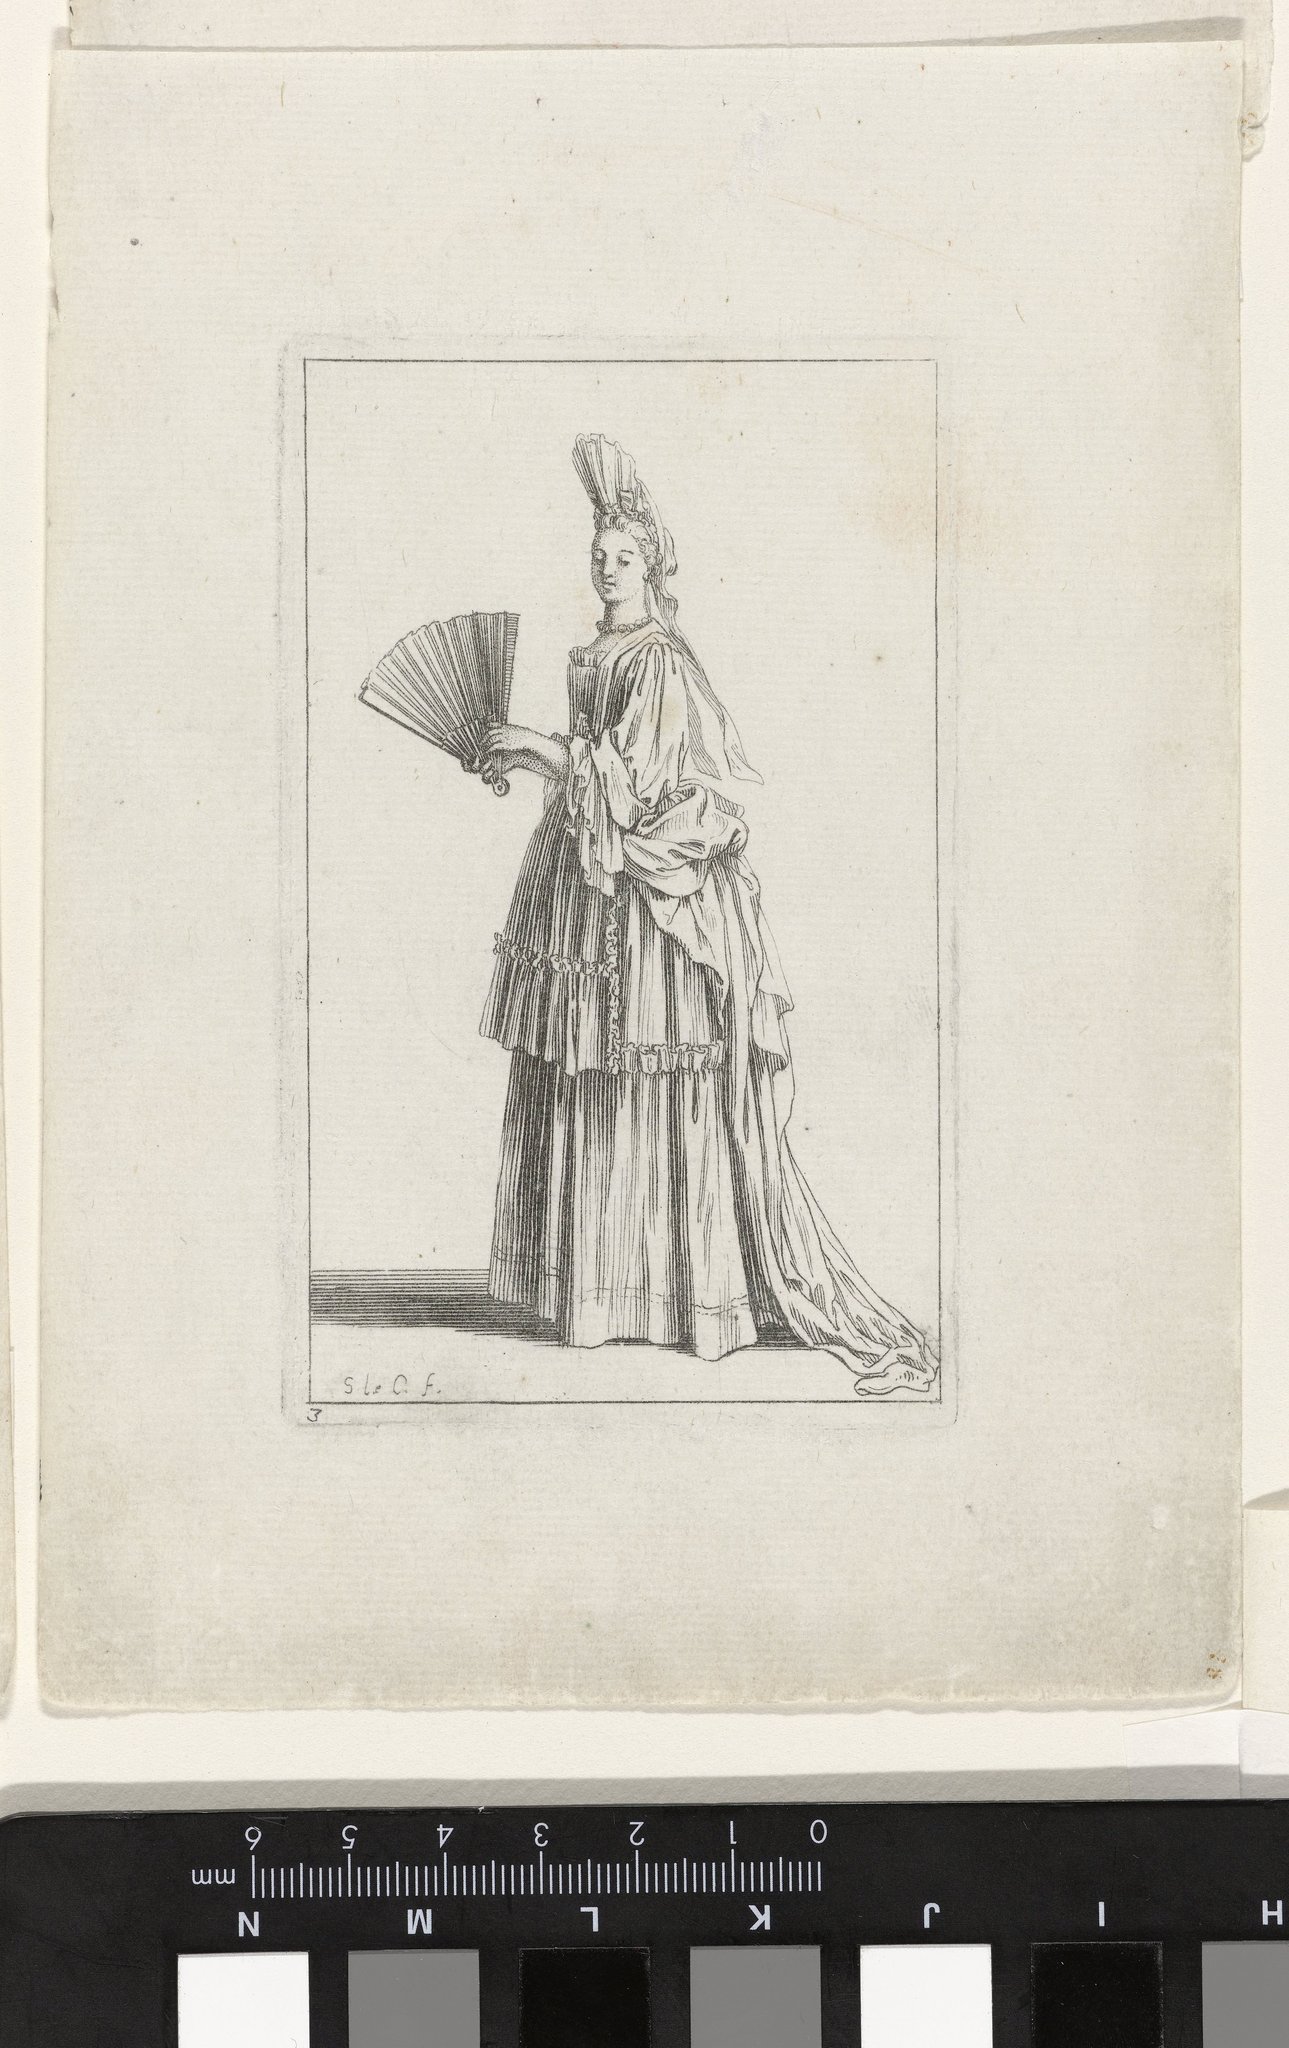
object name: print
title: Figures a la mode dédiées à M. le Duc de Bourgogne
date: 1715-1720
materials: paper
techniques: etching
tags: skirt (underskirt) (+ women's clothes), skirt (+ women's clothes), head-gear: fontange (+ women's clothes), dress, gown: manteau (+ women's clothes), sleeves (+ women's clothes), clothing for the upper part of the body (with name) (+ women's clothes)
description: Dame naar links, fontangemuts op het hoofd, opengeklapte vouwwaaier in de handen. Ze is gekleed in een 'manteau' met sleepje. No. 3 uit de serie Figures à la mode.